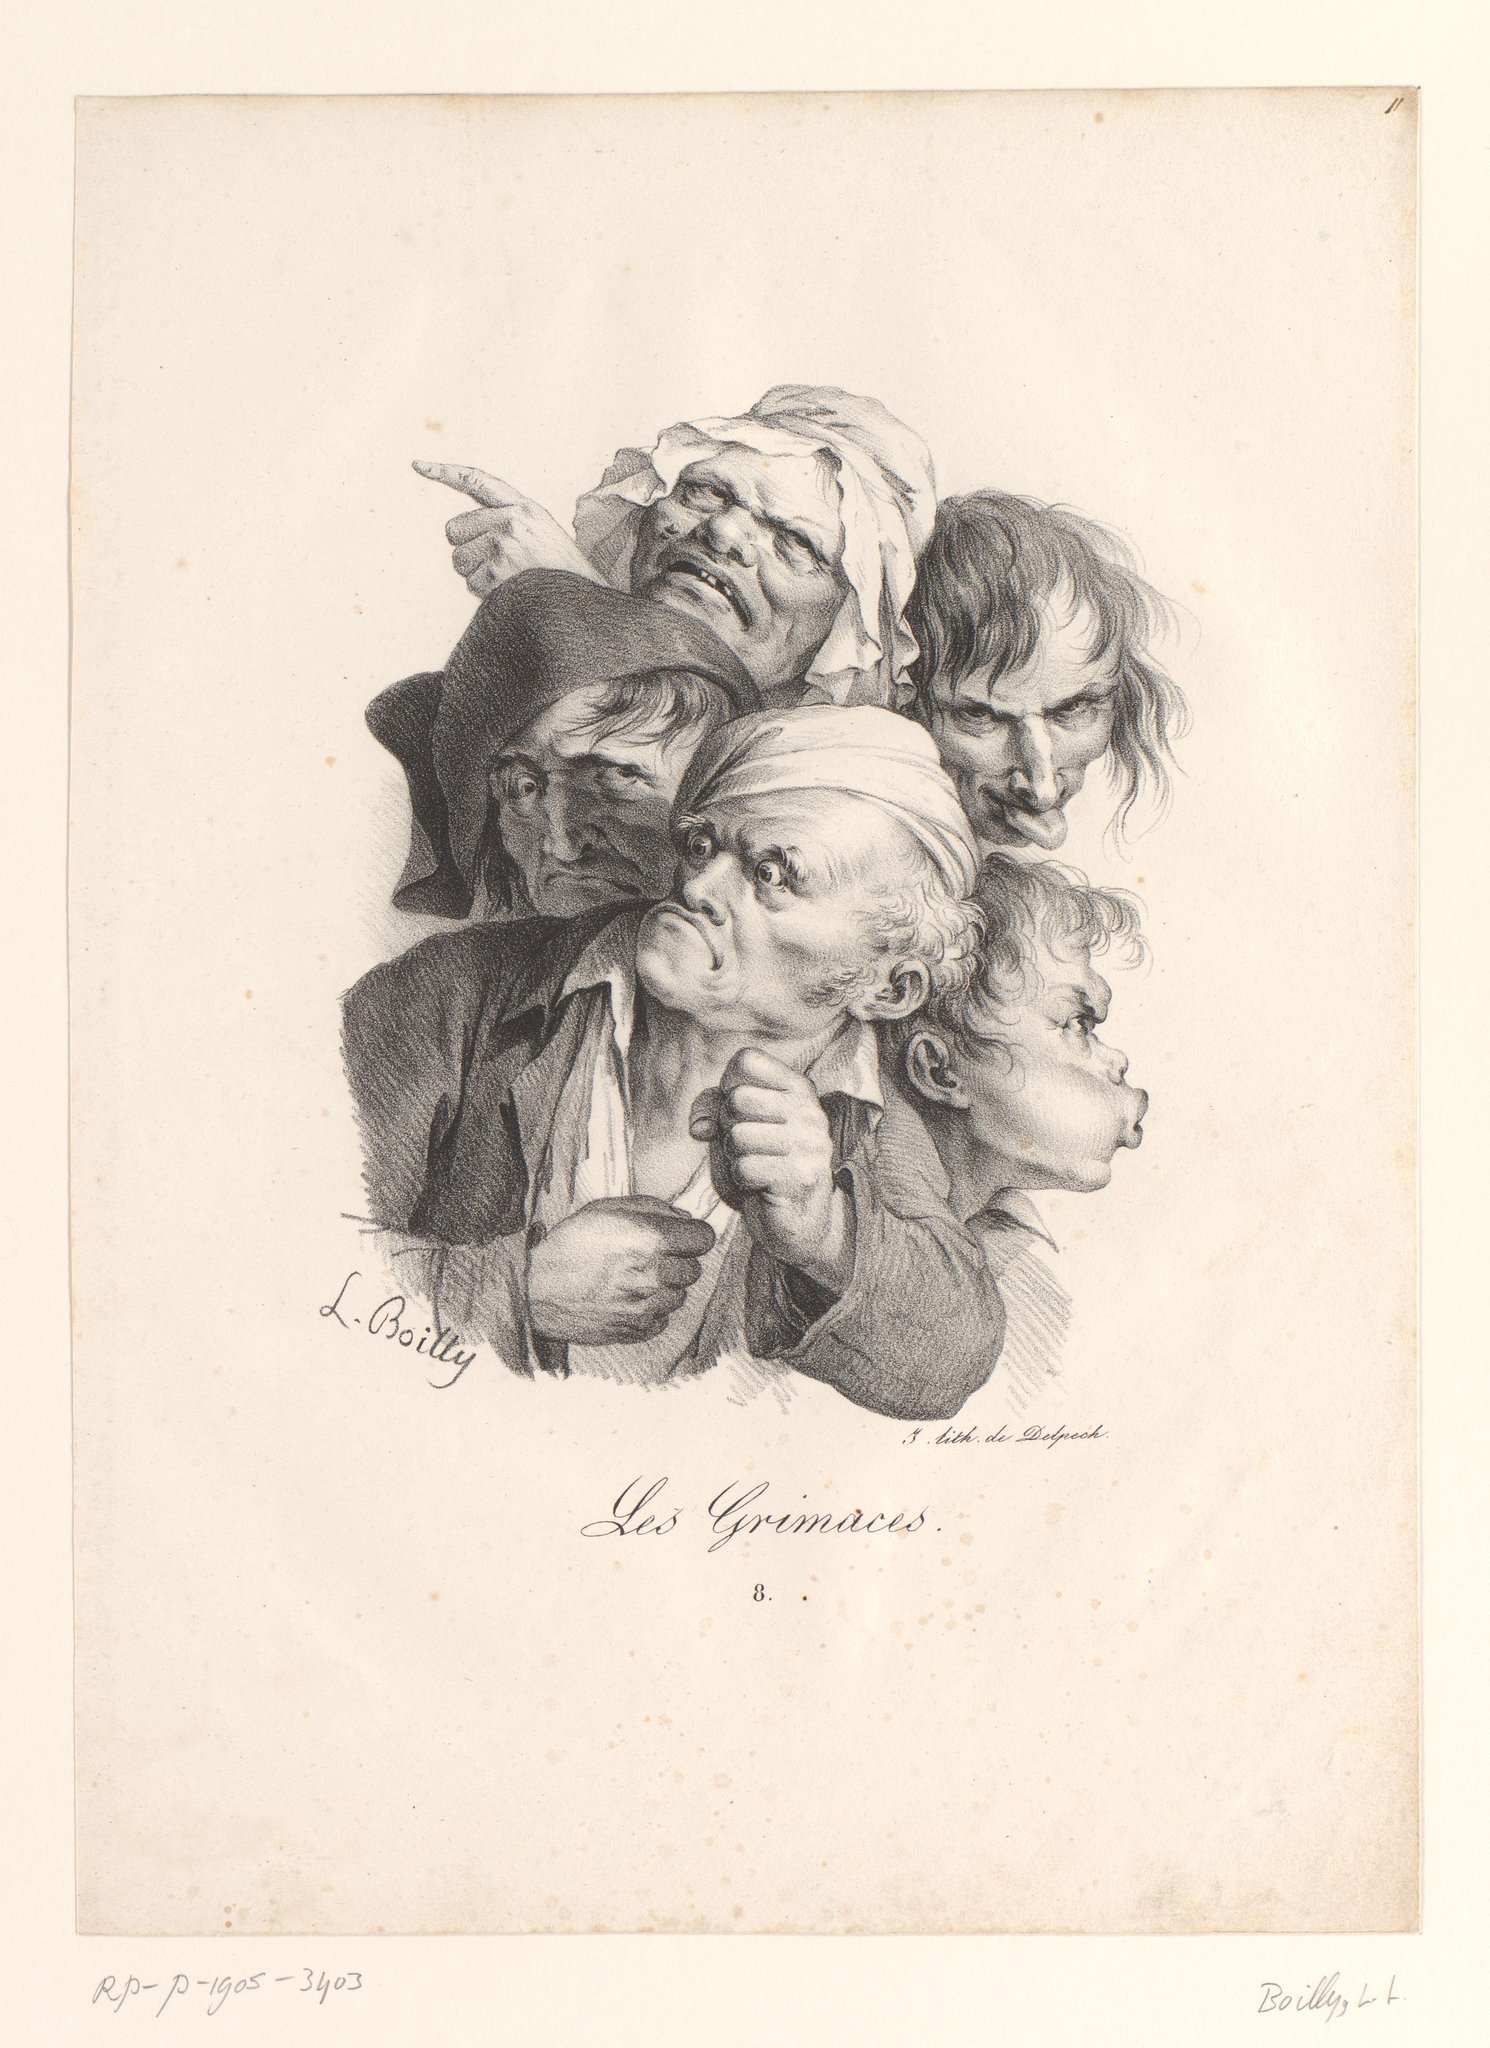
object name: print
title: Les Grimaces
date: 1823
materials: paper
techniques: lithograph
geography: paris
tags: caricatures (human types), morphology of facial expression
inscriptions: collector's mark: Lugt 2228a